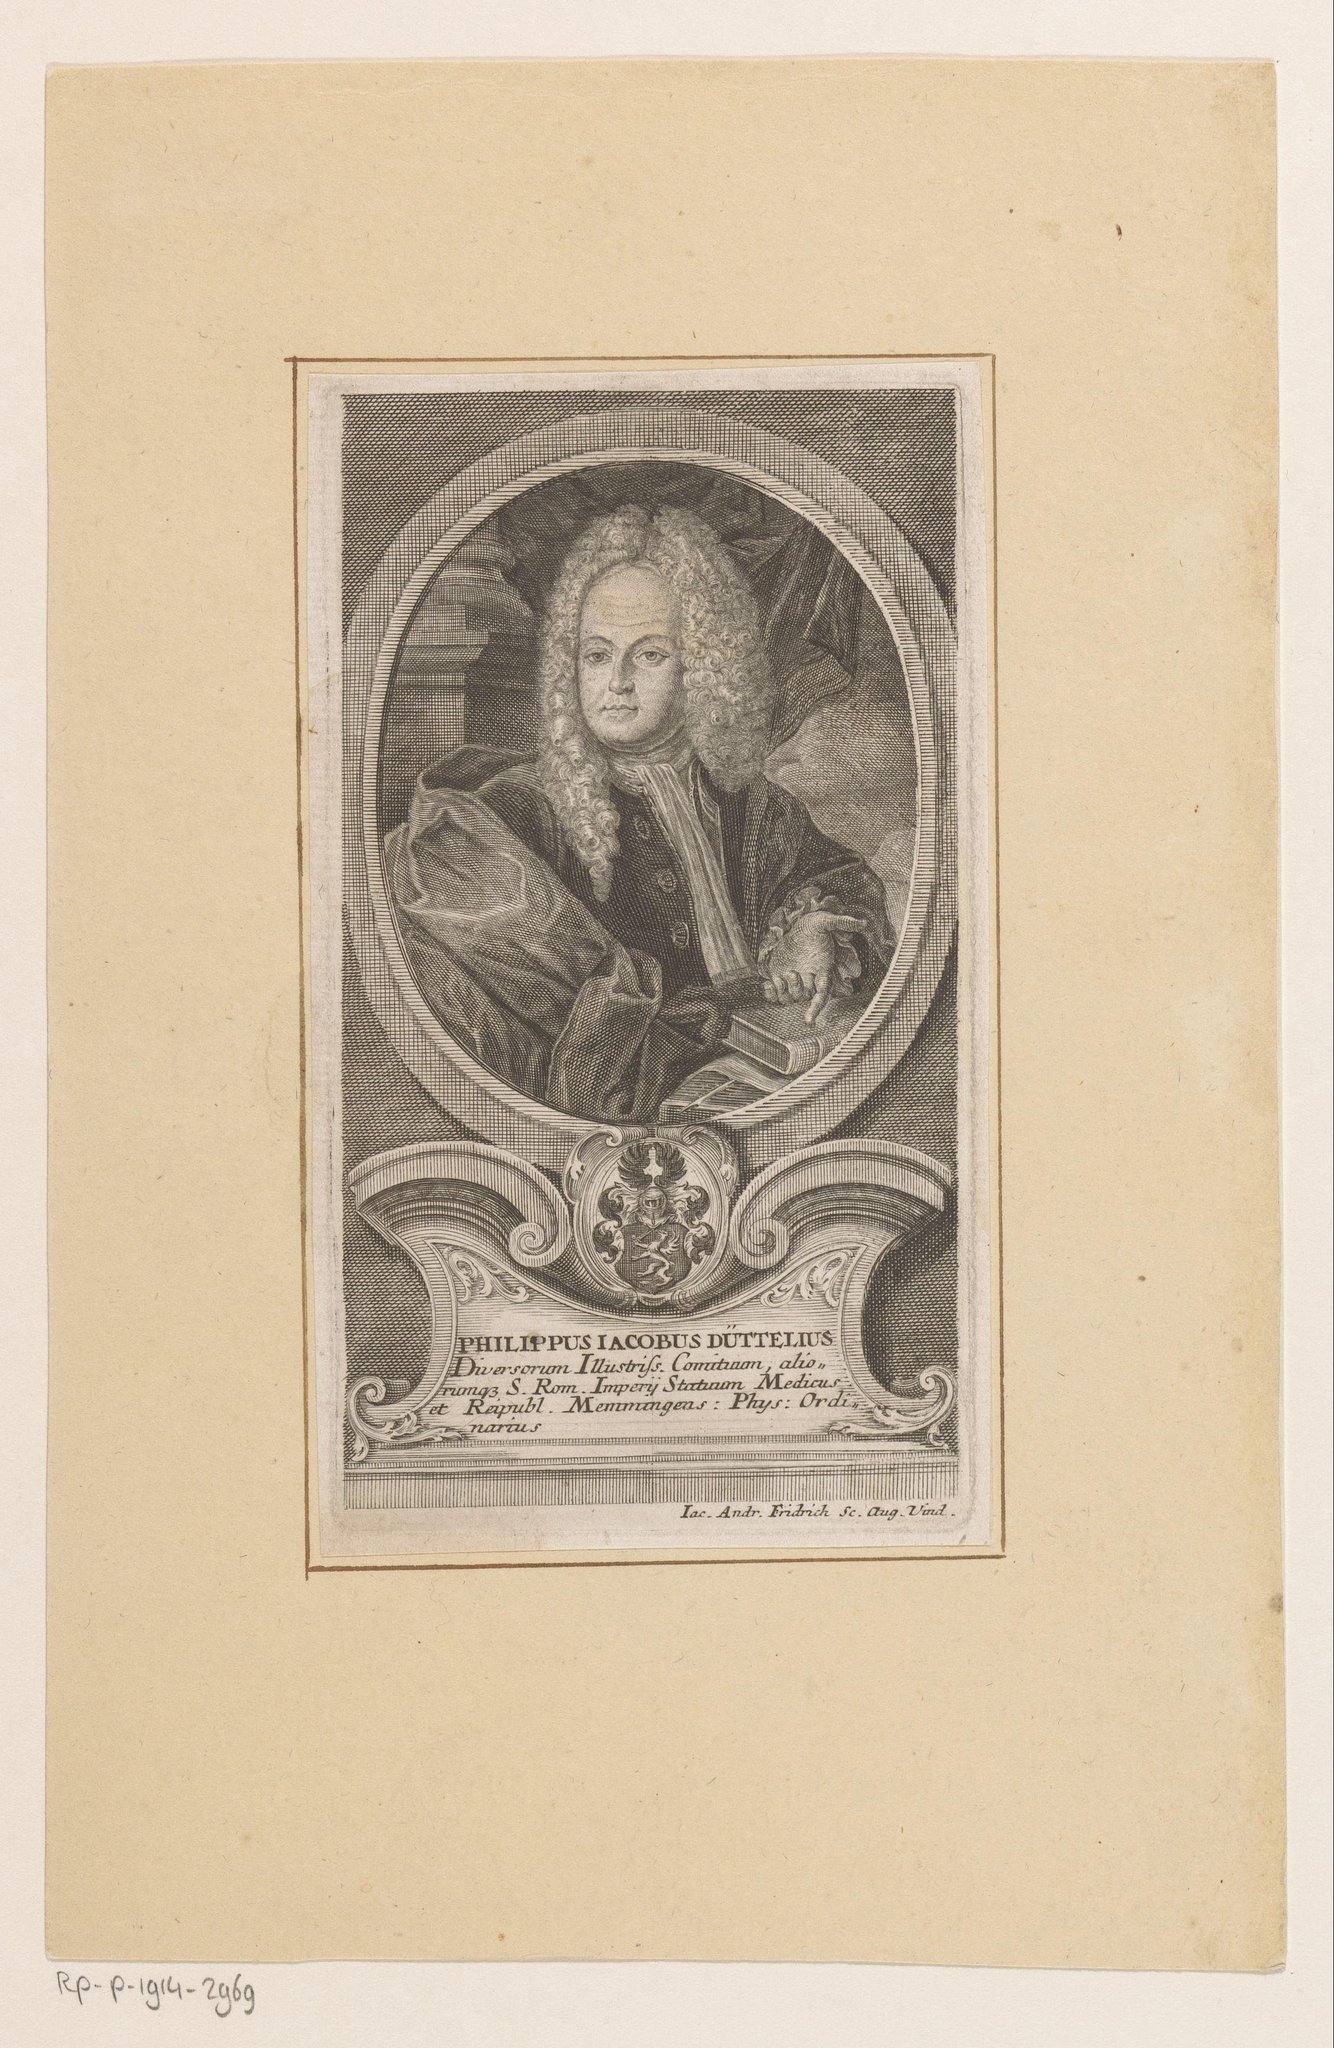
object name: print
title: Portret van Philipp Jacob Düttel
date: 1702-1737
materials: paper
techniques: engraving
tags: historical persons, physician, doctor, ornament derived from architectural details, armorial bearing, heraldry